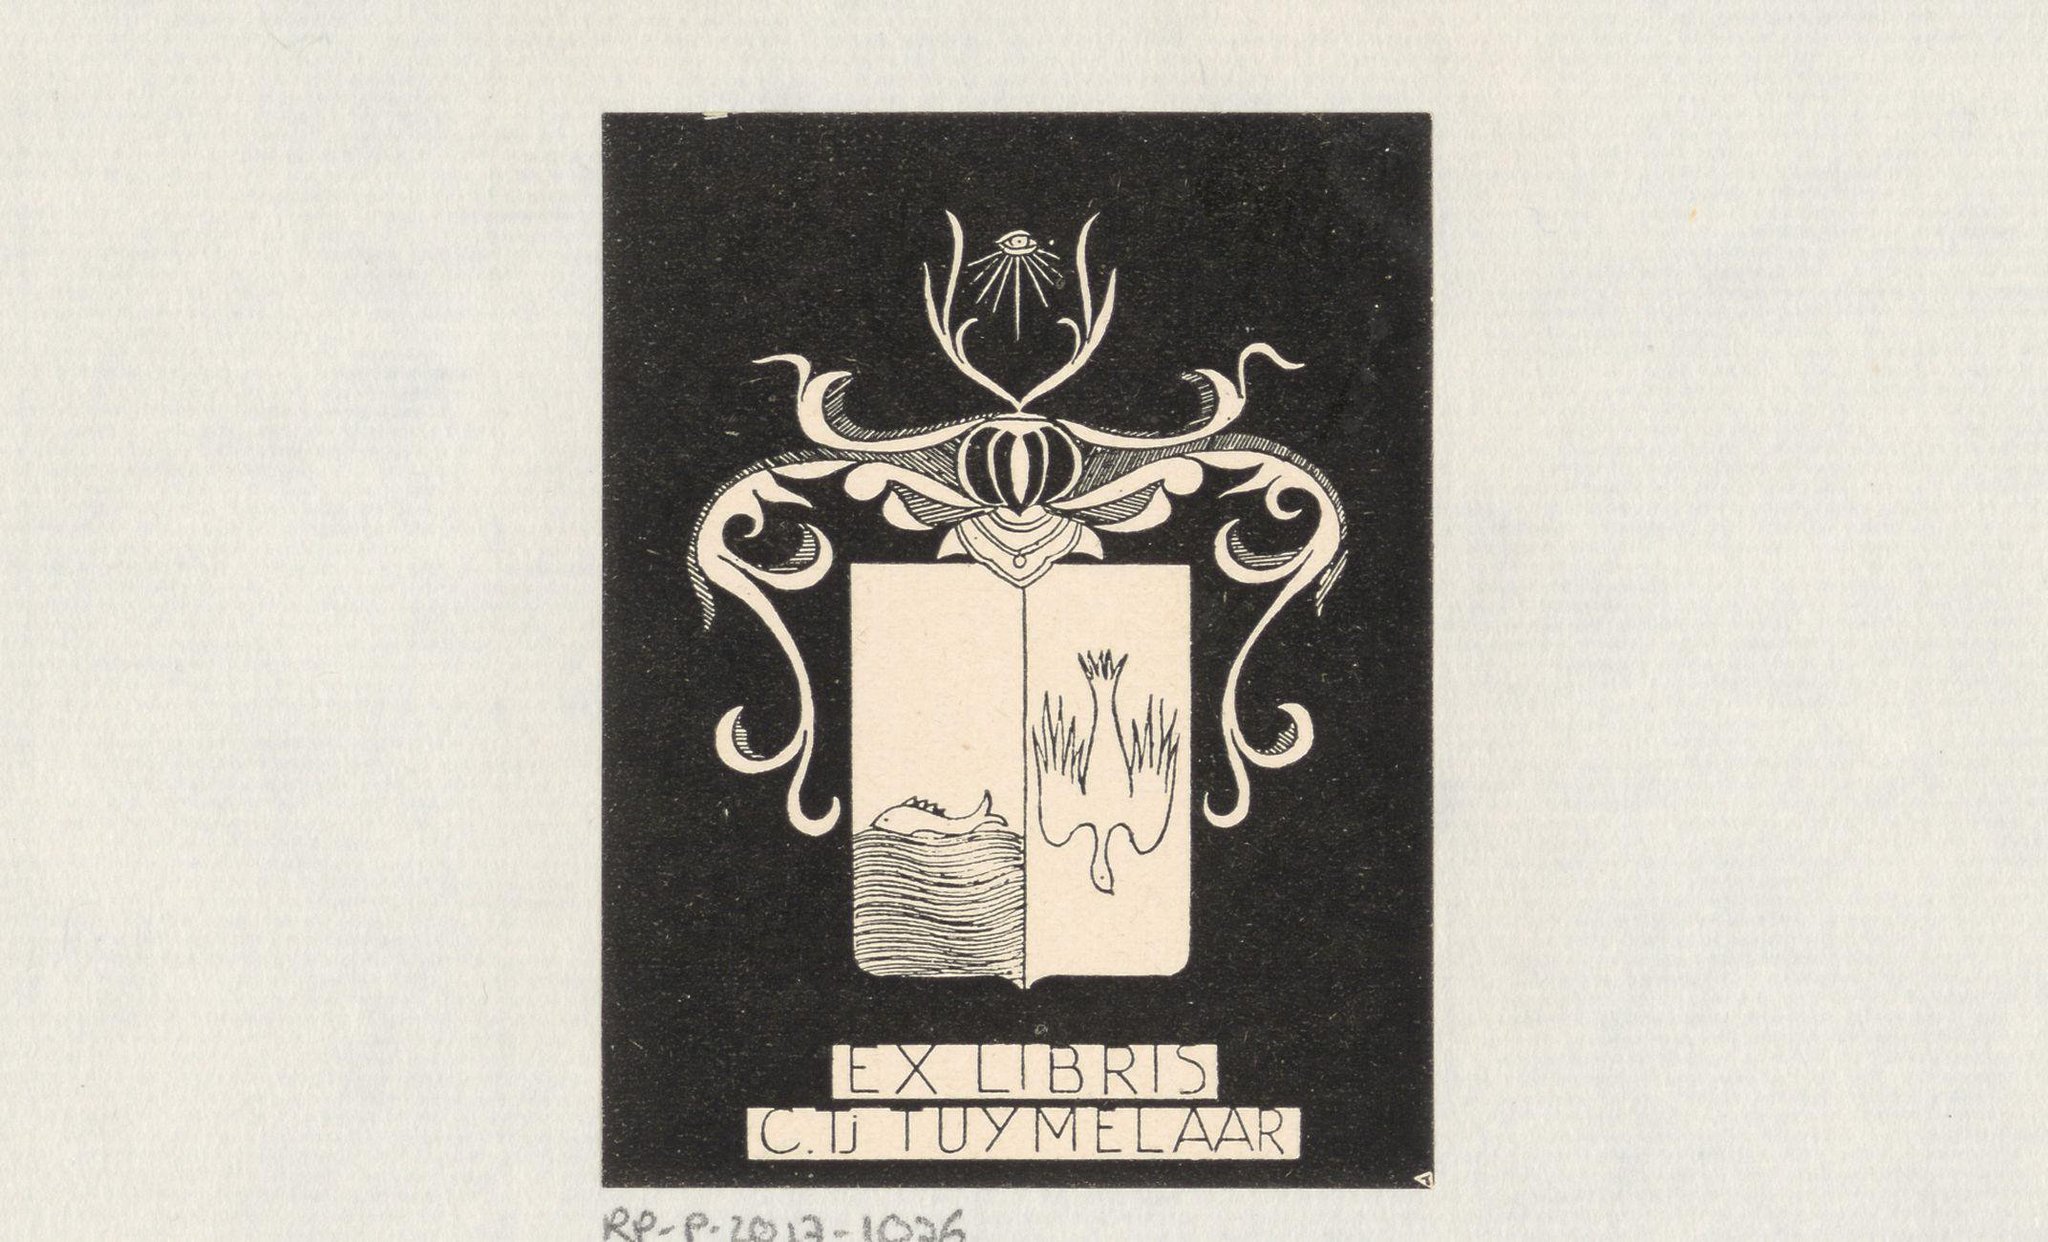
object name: bookplate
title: Ex libris van C.Tj. Tuymelaar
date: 1939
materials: paper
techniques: printing block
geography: netherlands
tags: c.tj. tuymelaar, birds, fishes, armorial bearing, heraldry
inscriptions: signature, date and inscription: ‘CTj Tuymelaar / Cl. '39’